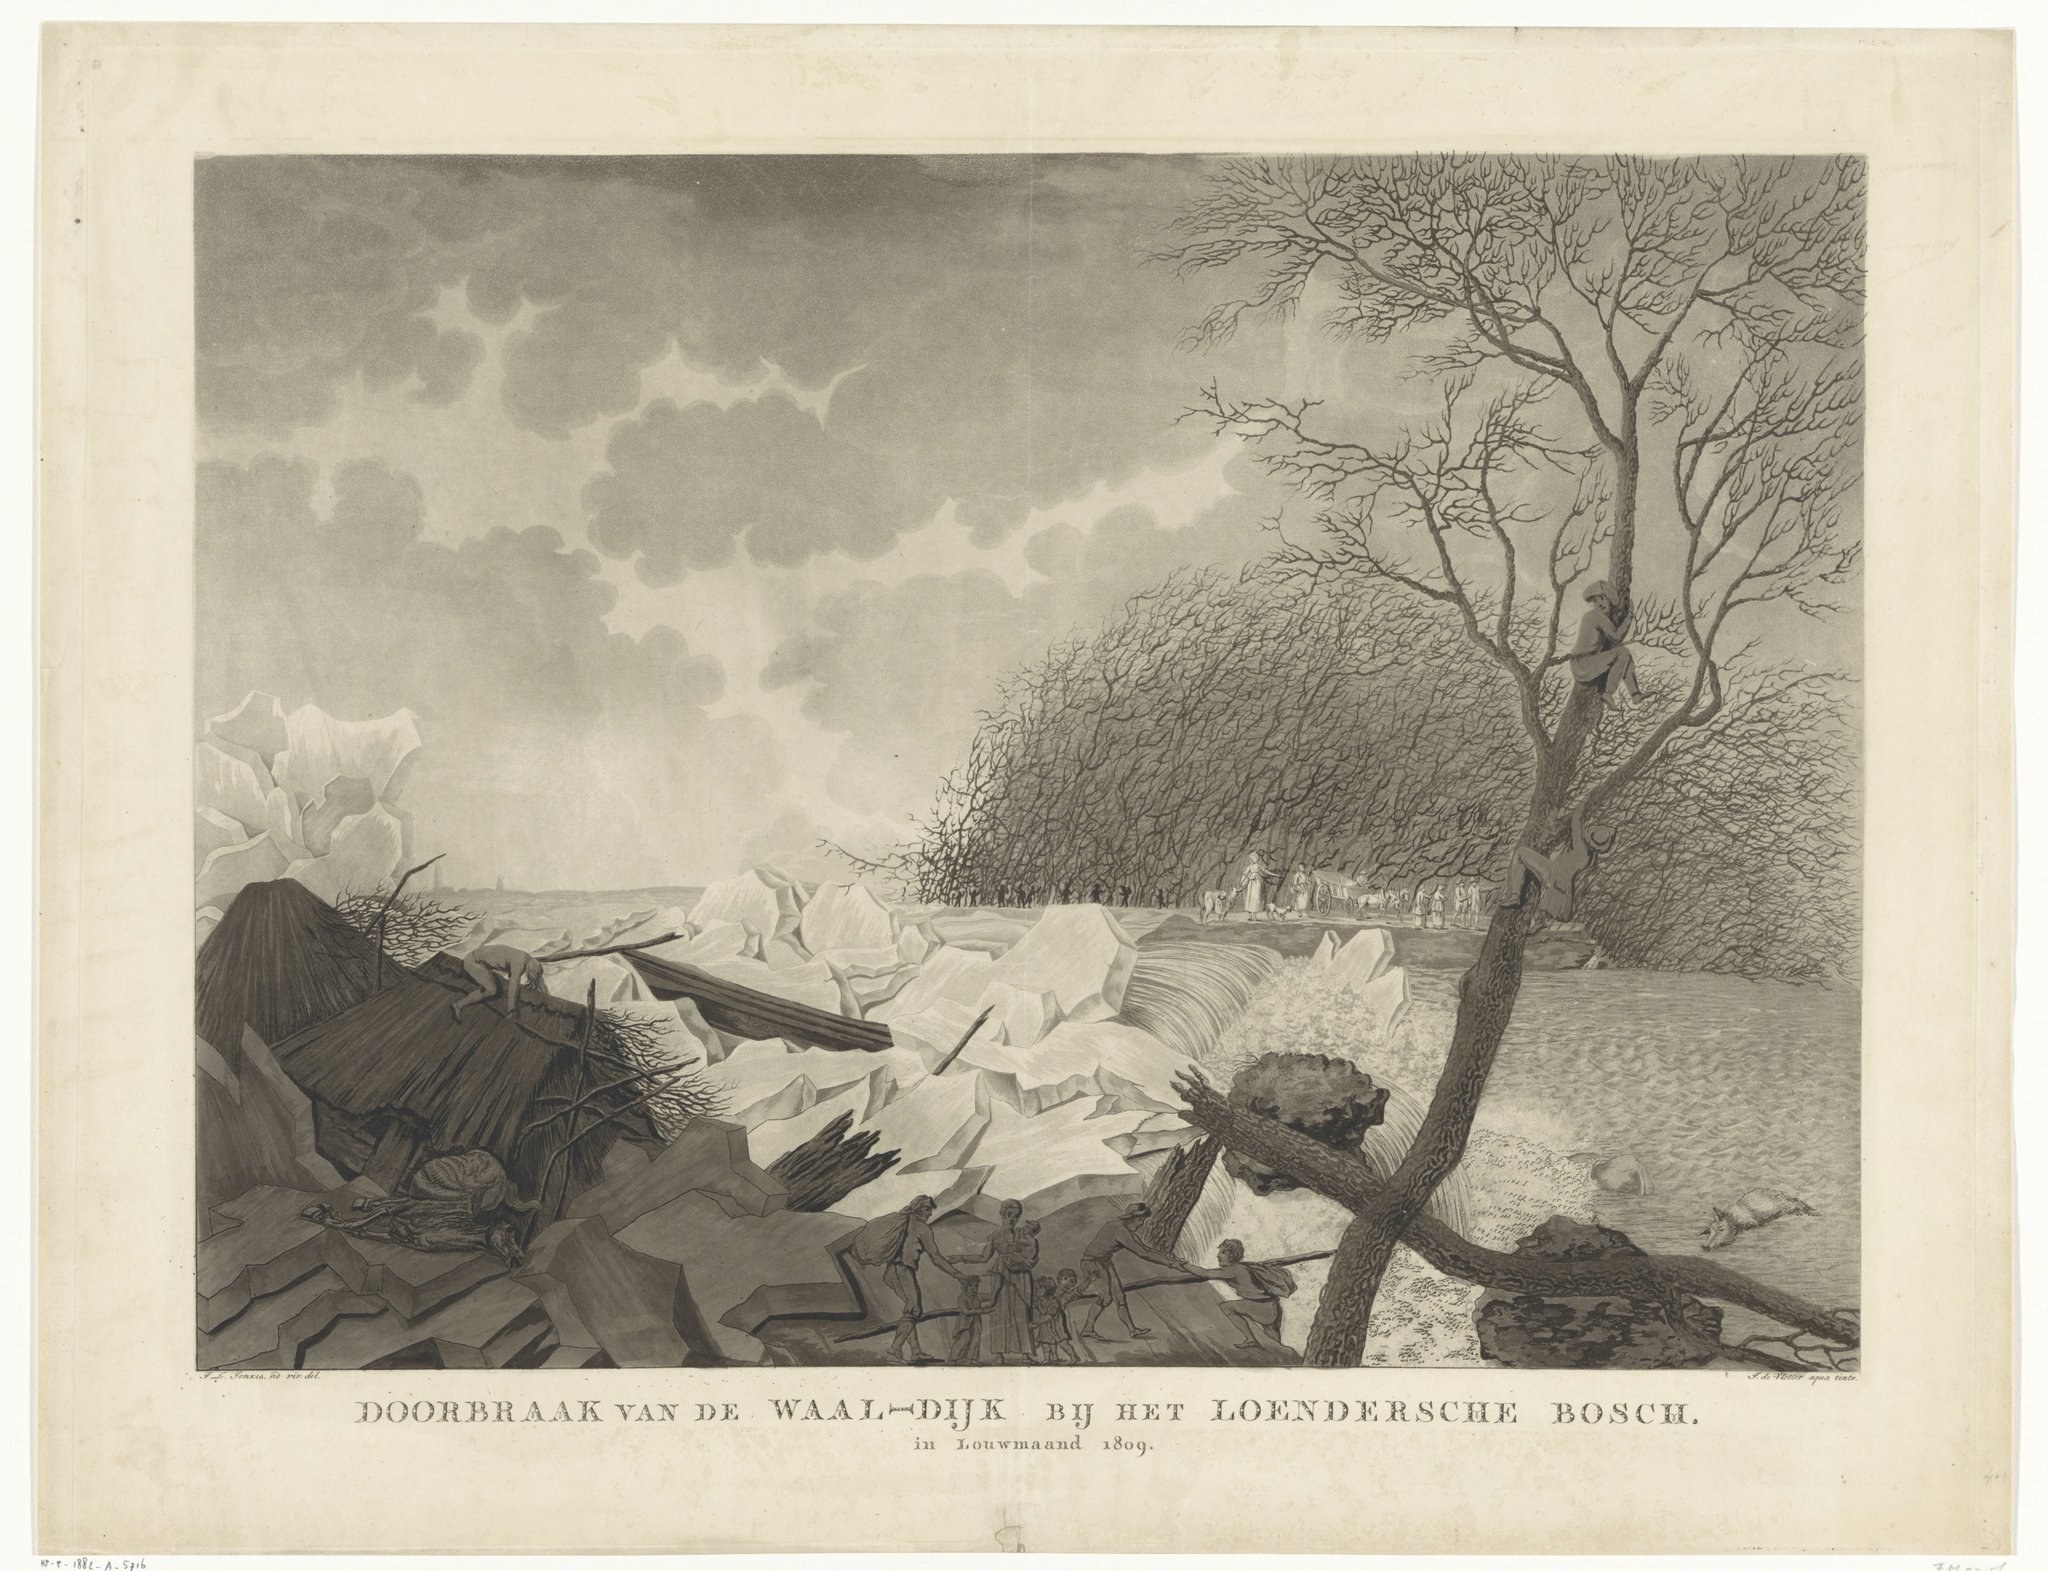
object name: print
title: Dijkdoorbraak van de Waaldijk bij Nijmegen, 1809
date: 1809-1811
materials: paper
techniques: aquatint, etching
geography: netherlands